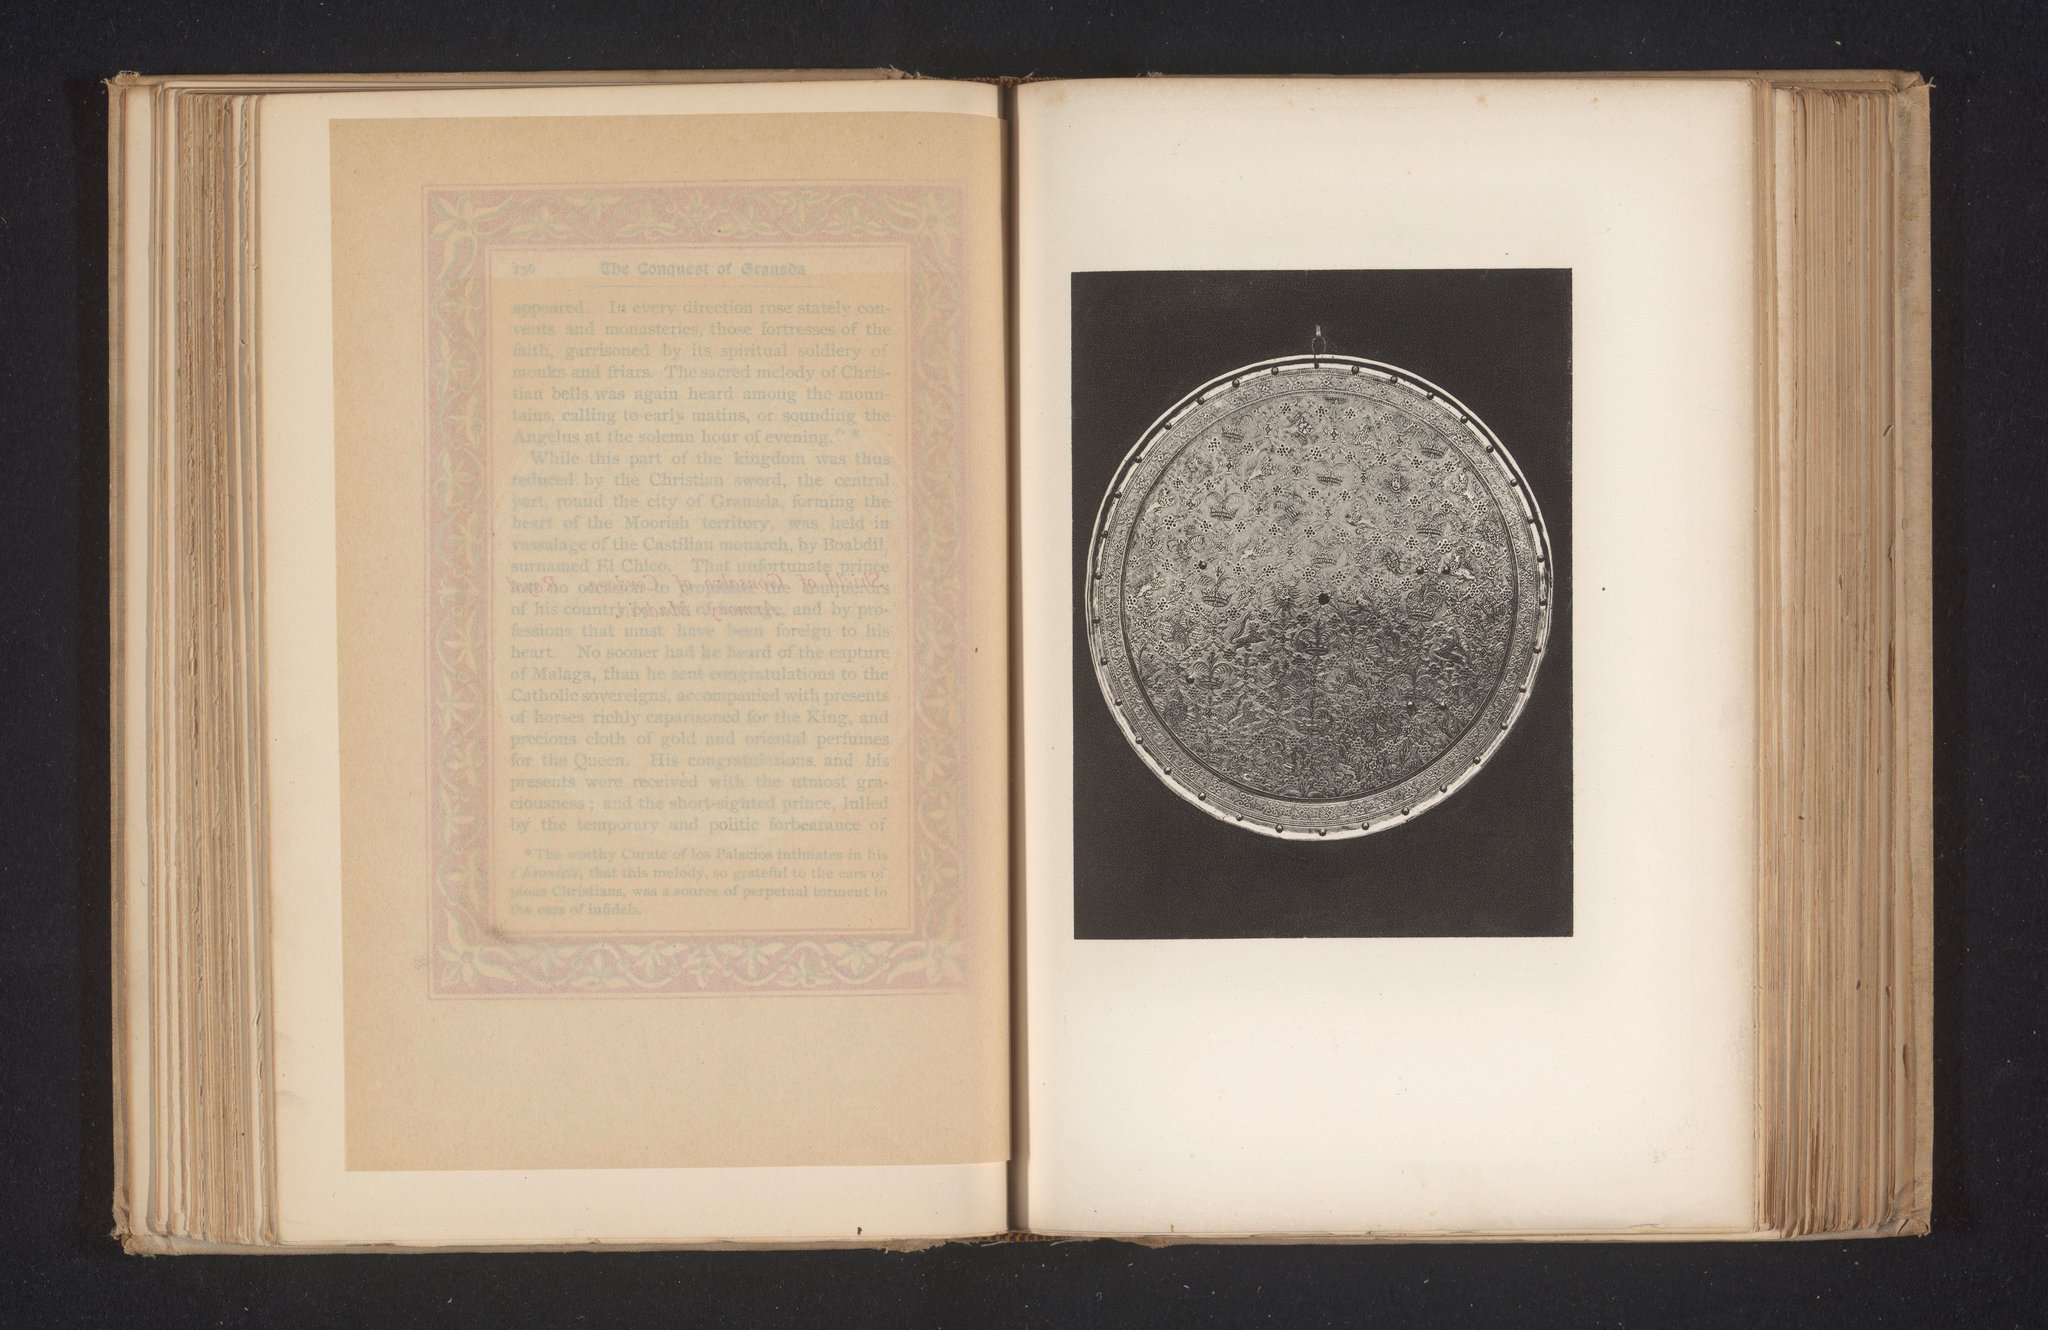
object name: photomechanical print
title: Schild van Gonzalo Fernández de Córdoba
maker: Anonymous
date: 1883-1893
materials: paper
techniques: photoaquatint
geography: madrid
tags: protective weapons: shield